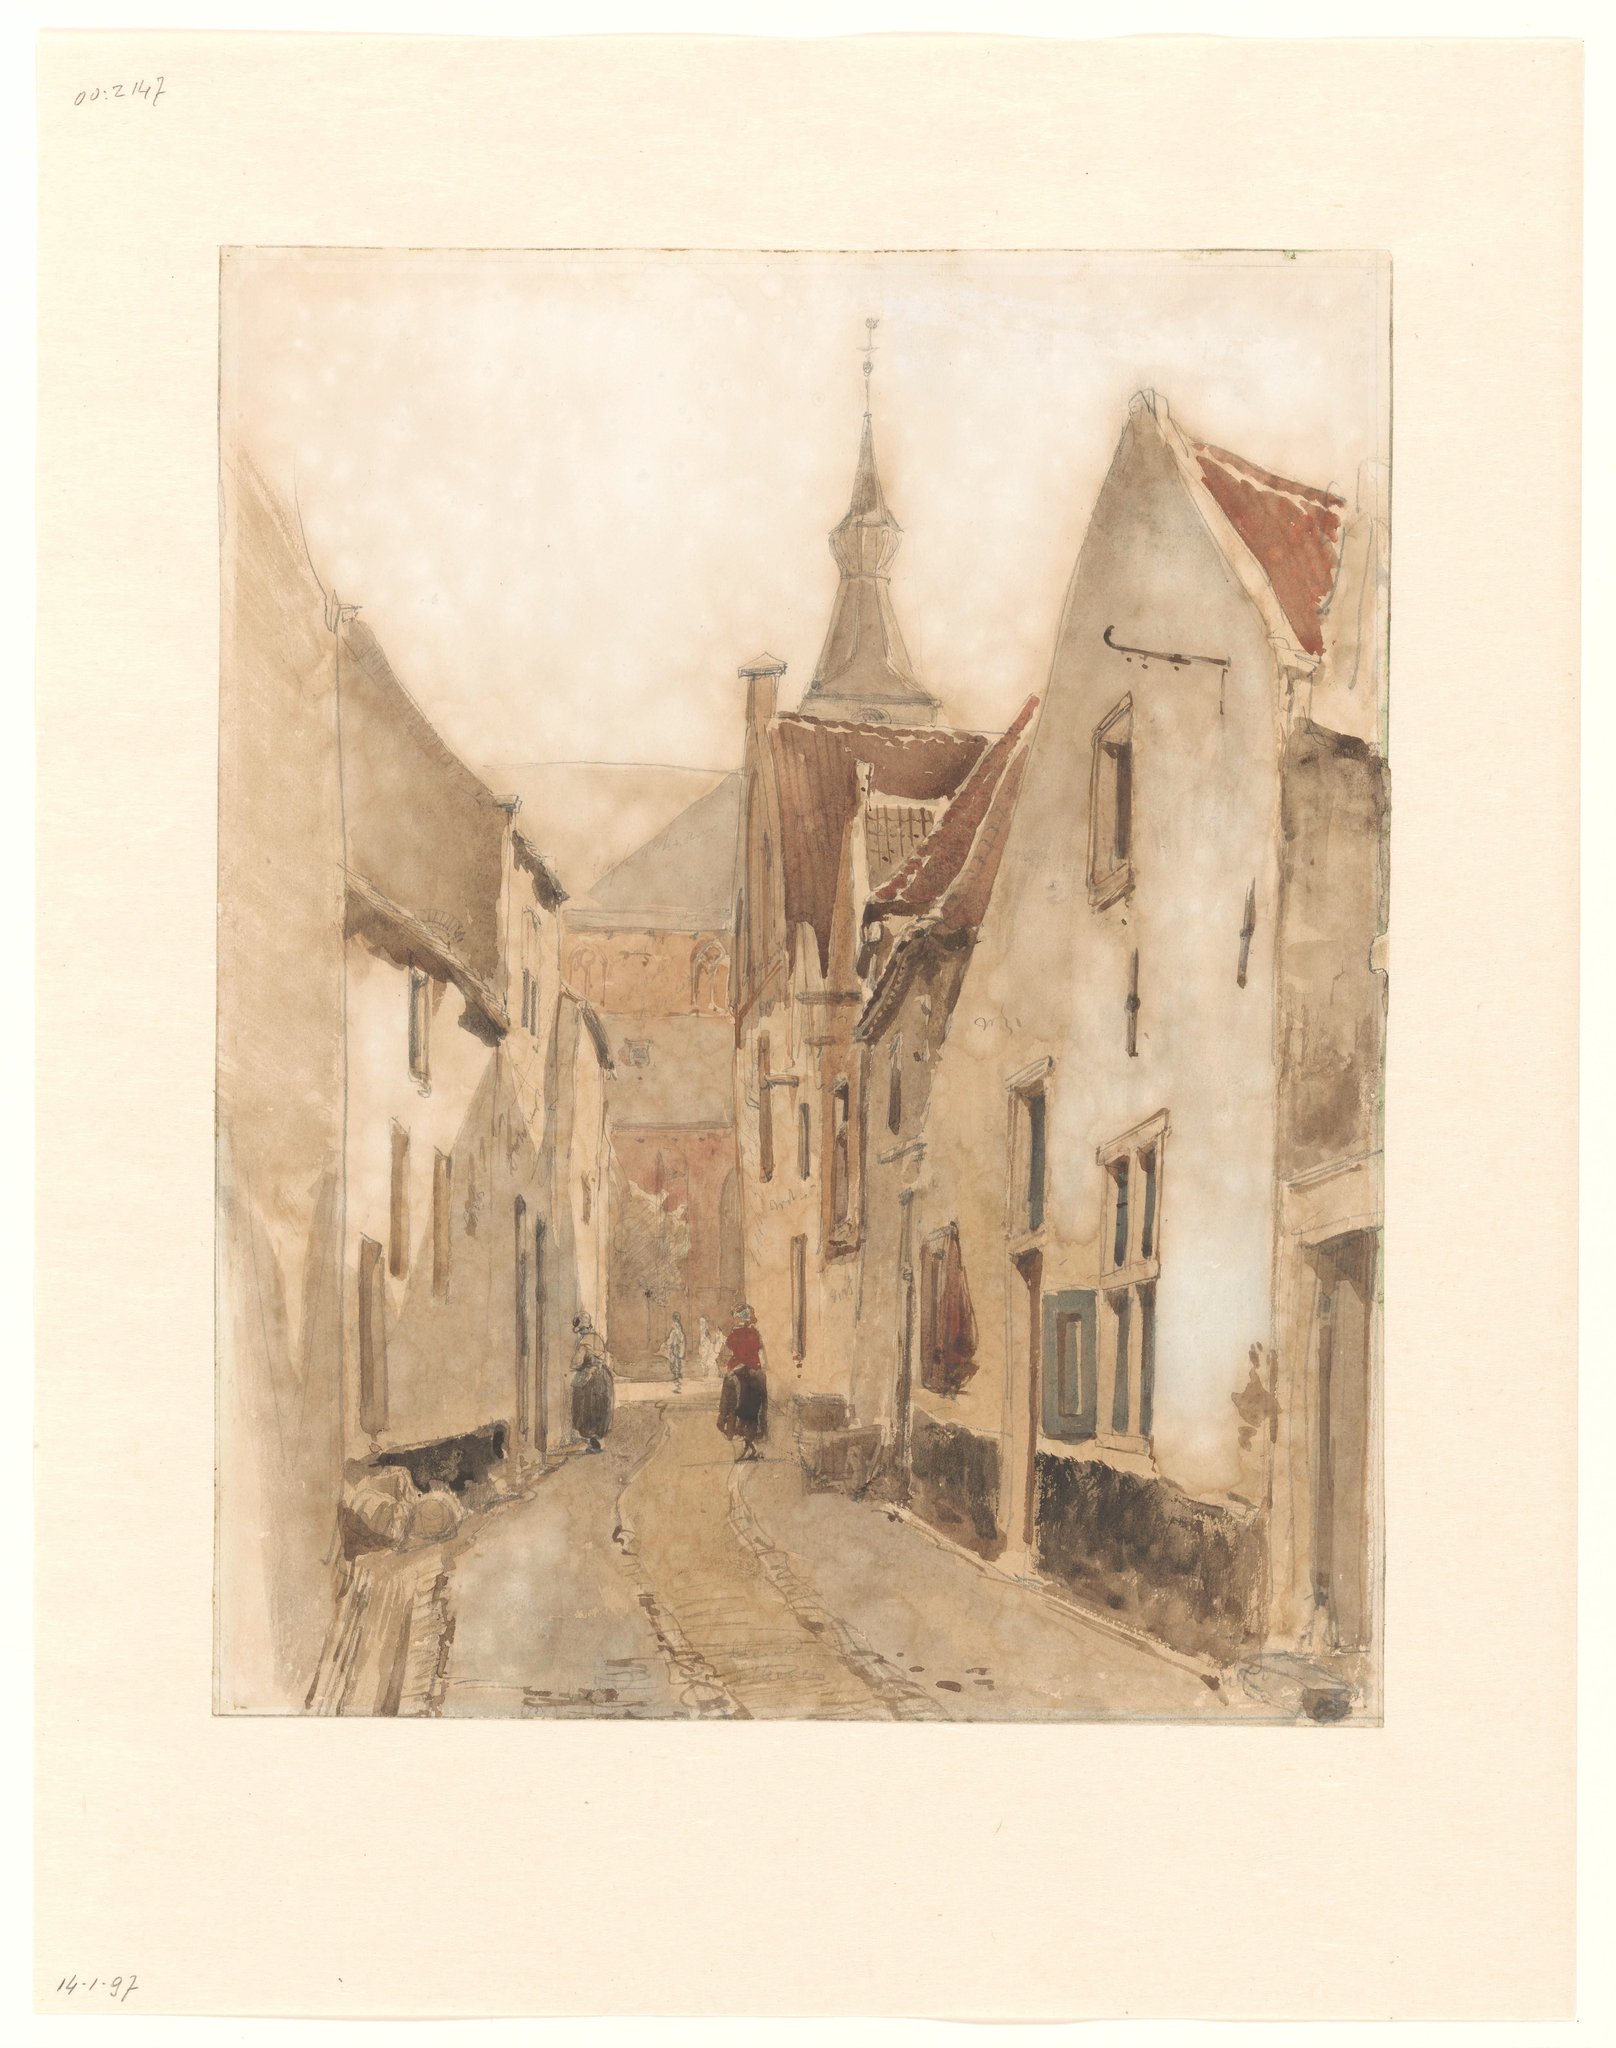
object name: watercolor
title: Gezicht vanuit de Ridderstraat in de Kerksteeg, Hattem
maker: johannes bosboom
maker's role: draughtsman, painter, print maker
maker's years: 1817-1891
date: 1861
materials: paper, pencil, watercolor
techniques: brush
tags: street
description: Gezicht vanuit de Ridderstraat in de Kerksteeg te Hattem. Op de achtergrond de Andreaskerk.